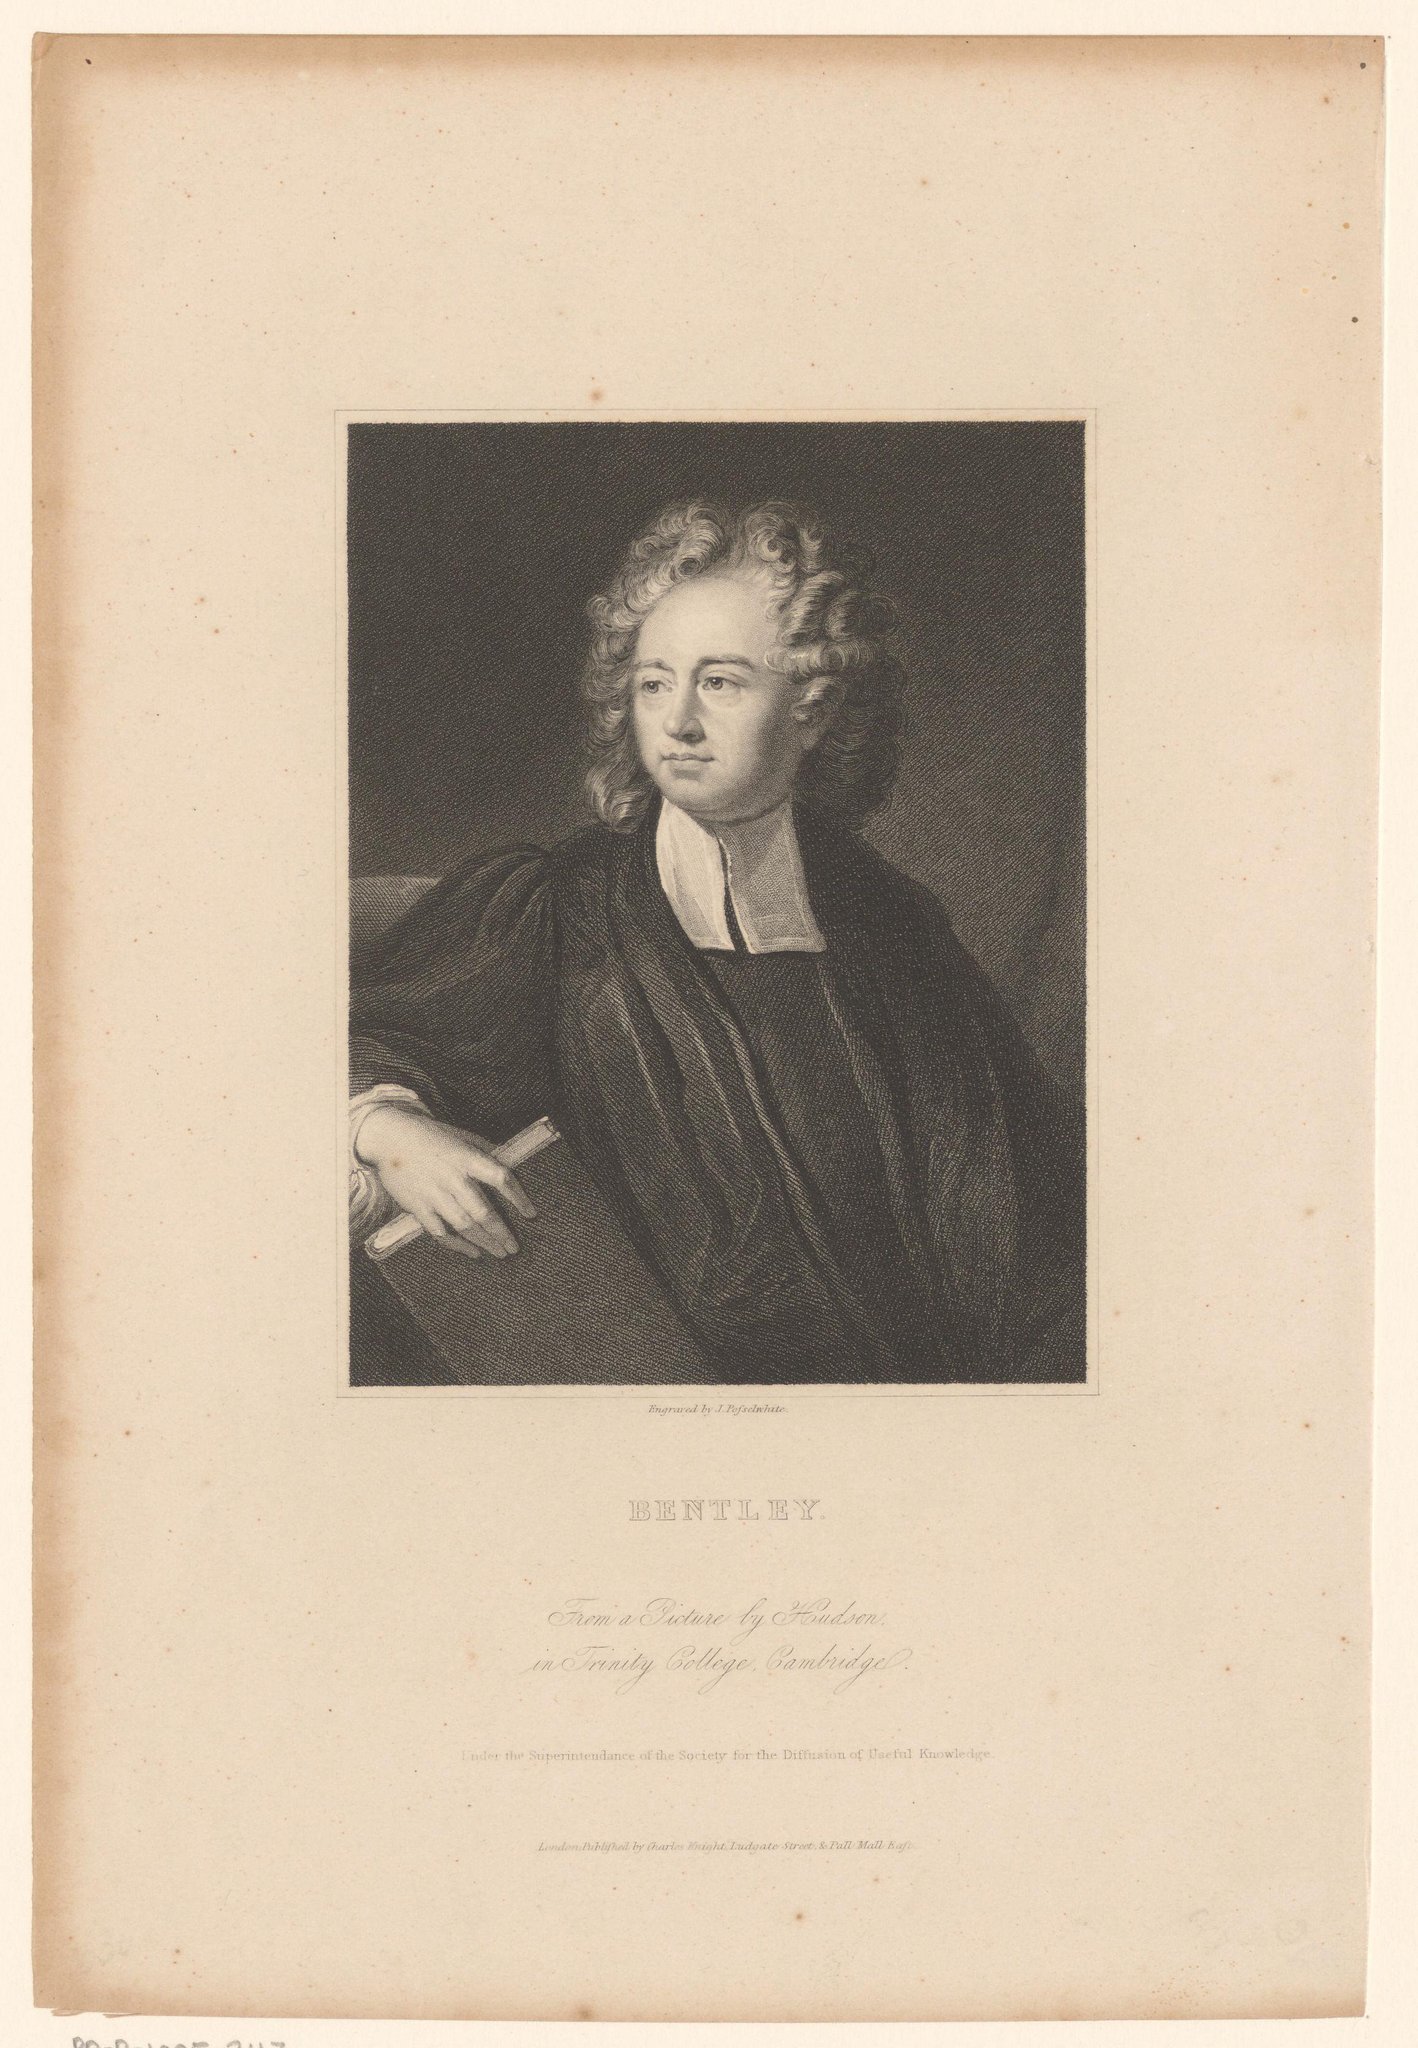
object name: book illustration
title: Portret van Richard Bentley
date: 1834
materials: paper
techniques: engraving, etching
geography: london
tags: theologian, historical persons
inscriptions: collector's mark: Lugt 2228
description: Prent uit: Malkin, Arthur Thomas. The Gallery of Portraits: with Memoirs. Londen: Charles Knight, 1834, dl. 3.